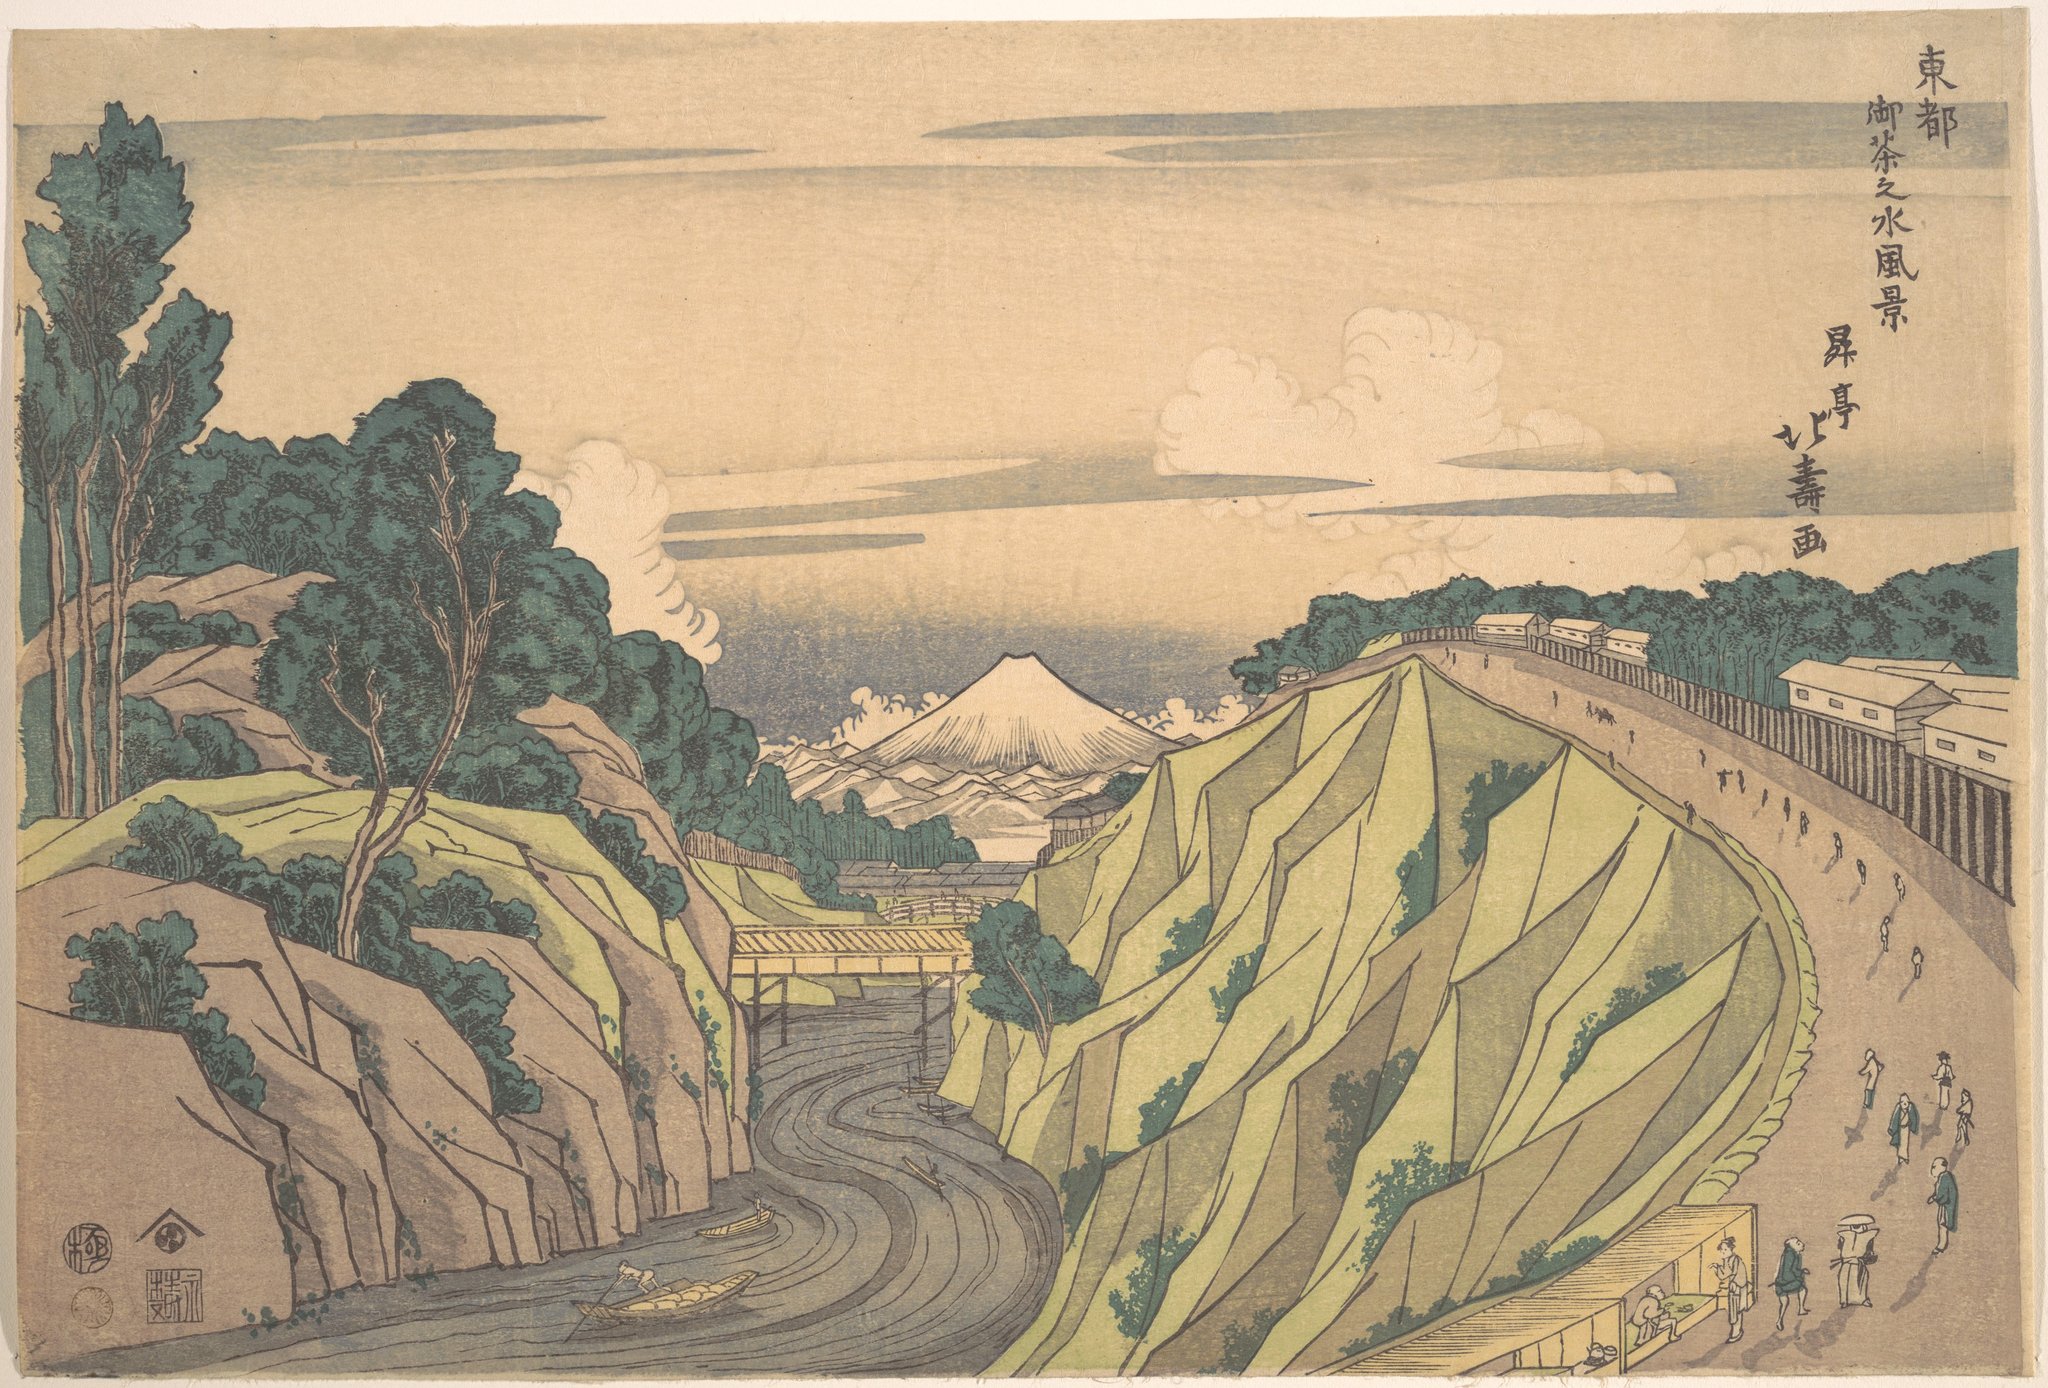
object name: print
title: View of Ochanomizu in the Eastern Capital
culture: japanese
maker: shōtei hokuju 昇亭北寿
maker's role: artist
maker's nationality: japanese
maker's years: 1790-1820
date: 1810-1820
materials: ink, paper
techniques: woodblock print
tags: bridges,roads,rivers,mountains,boats